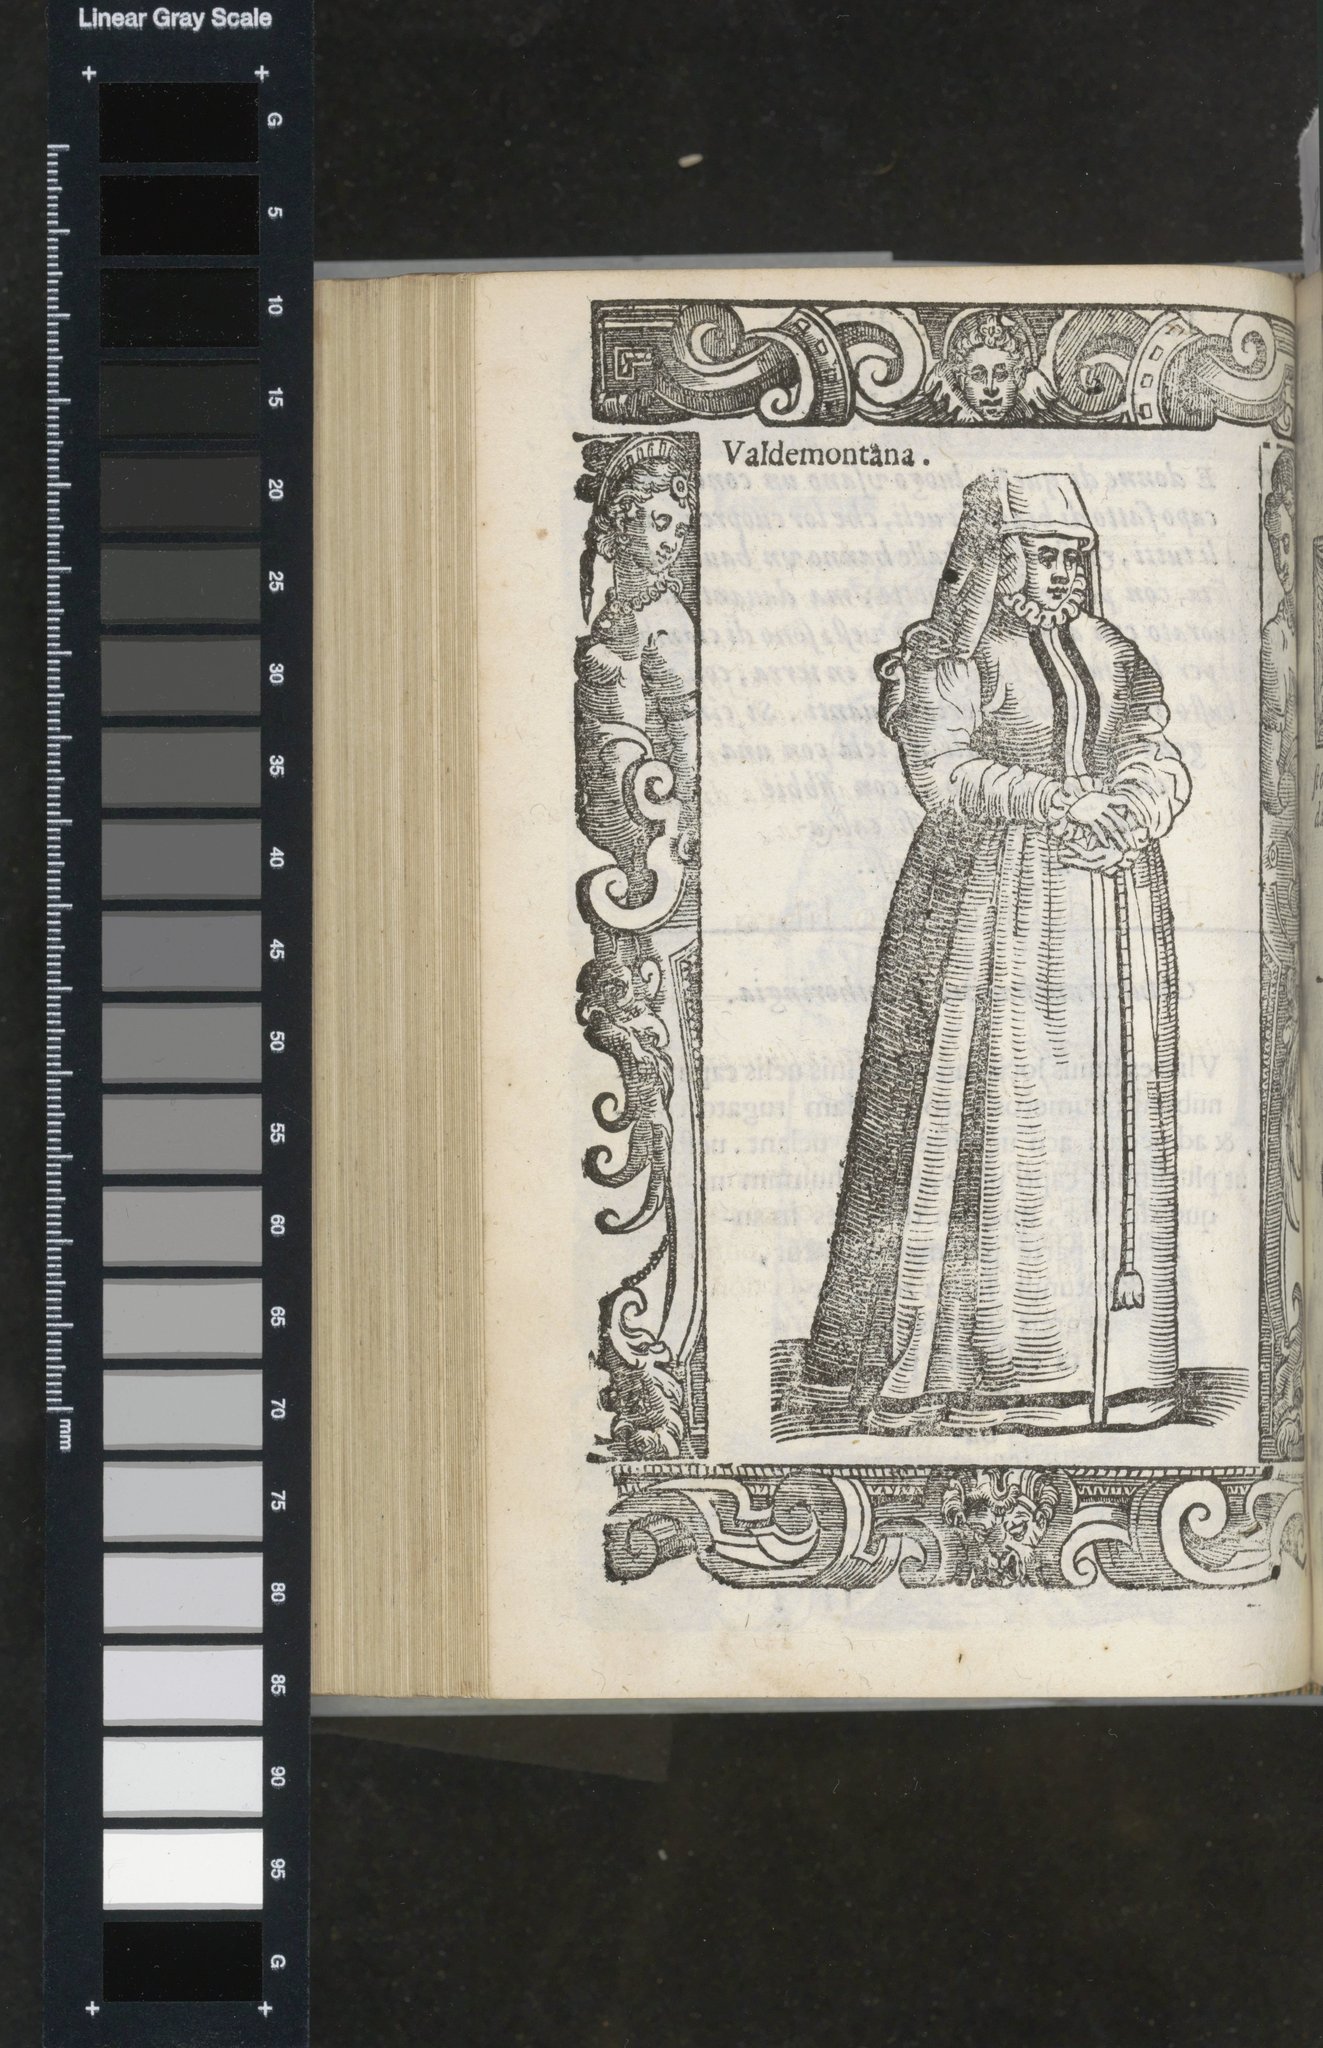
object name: costume print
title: Valdemontana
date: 1598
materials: paper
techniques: woodcut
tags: fashion plates